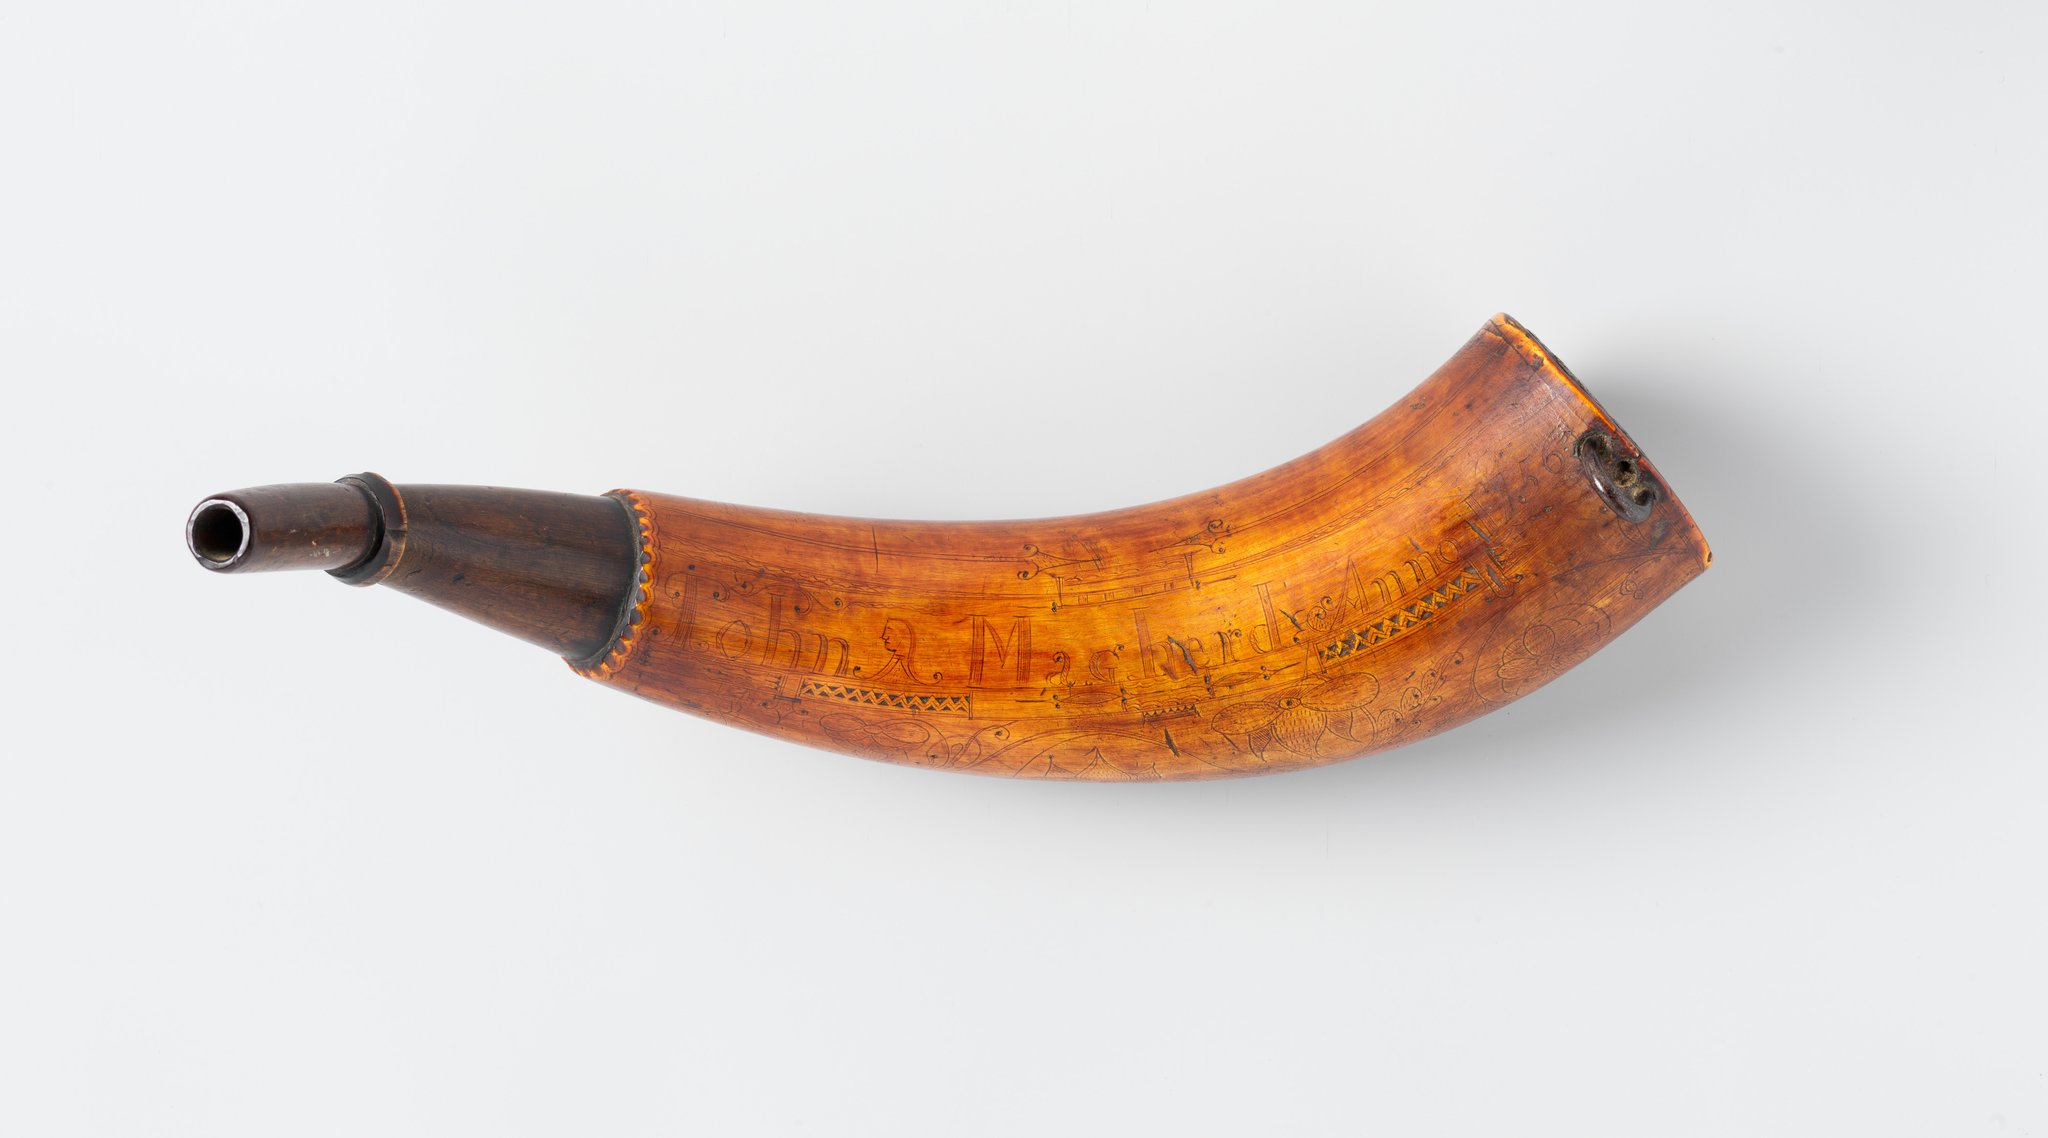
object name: powder horn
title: Powder Horn of John Mahard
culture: colonial american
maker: john bush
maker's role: artist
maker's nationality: american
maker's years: 1720-1763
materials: iron, wood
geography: united states